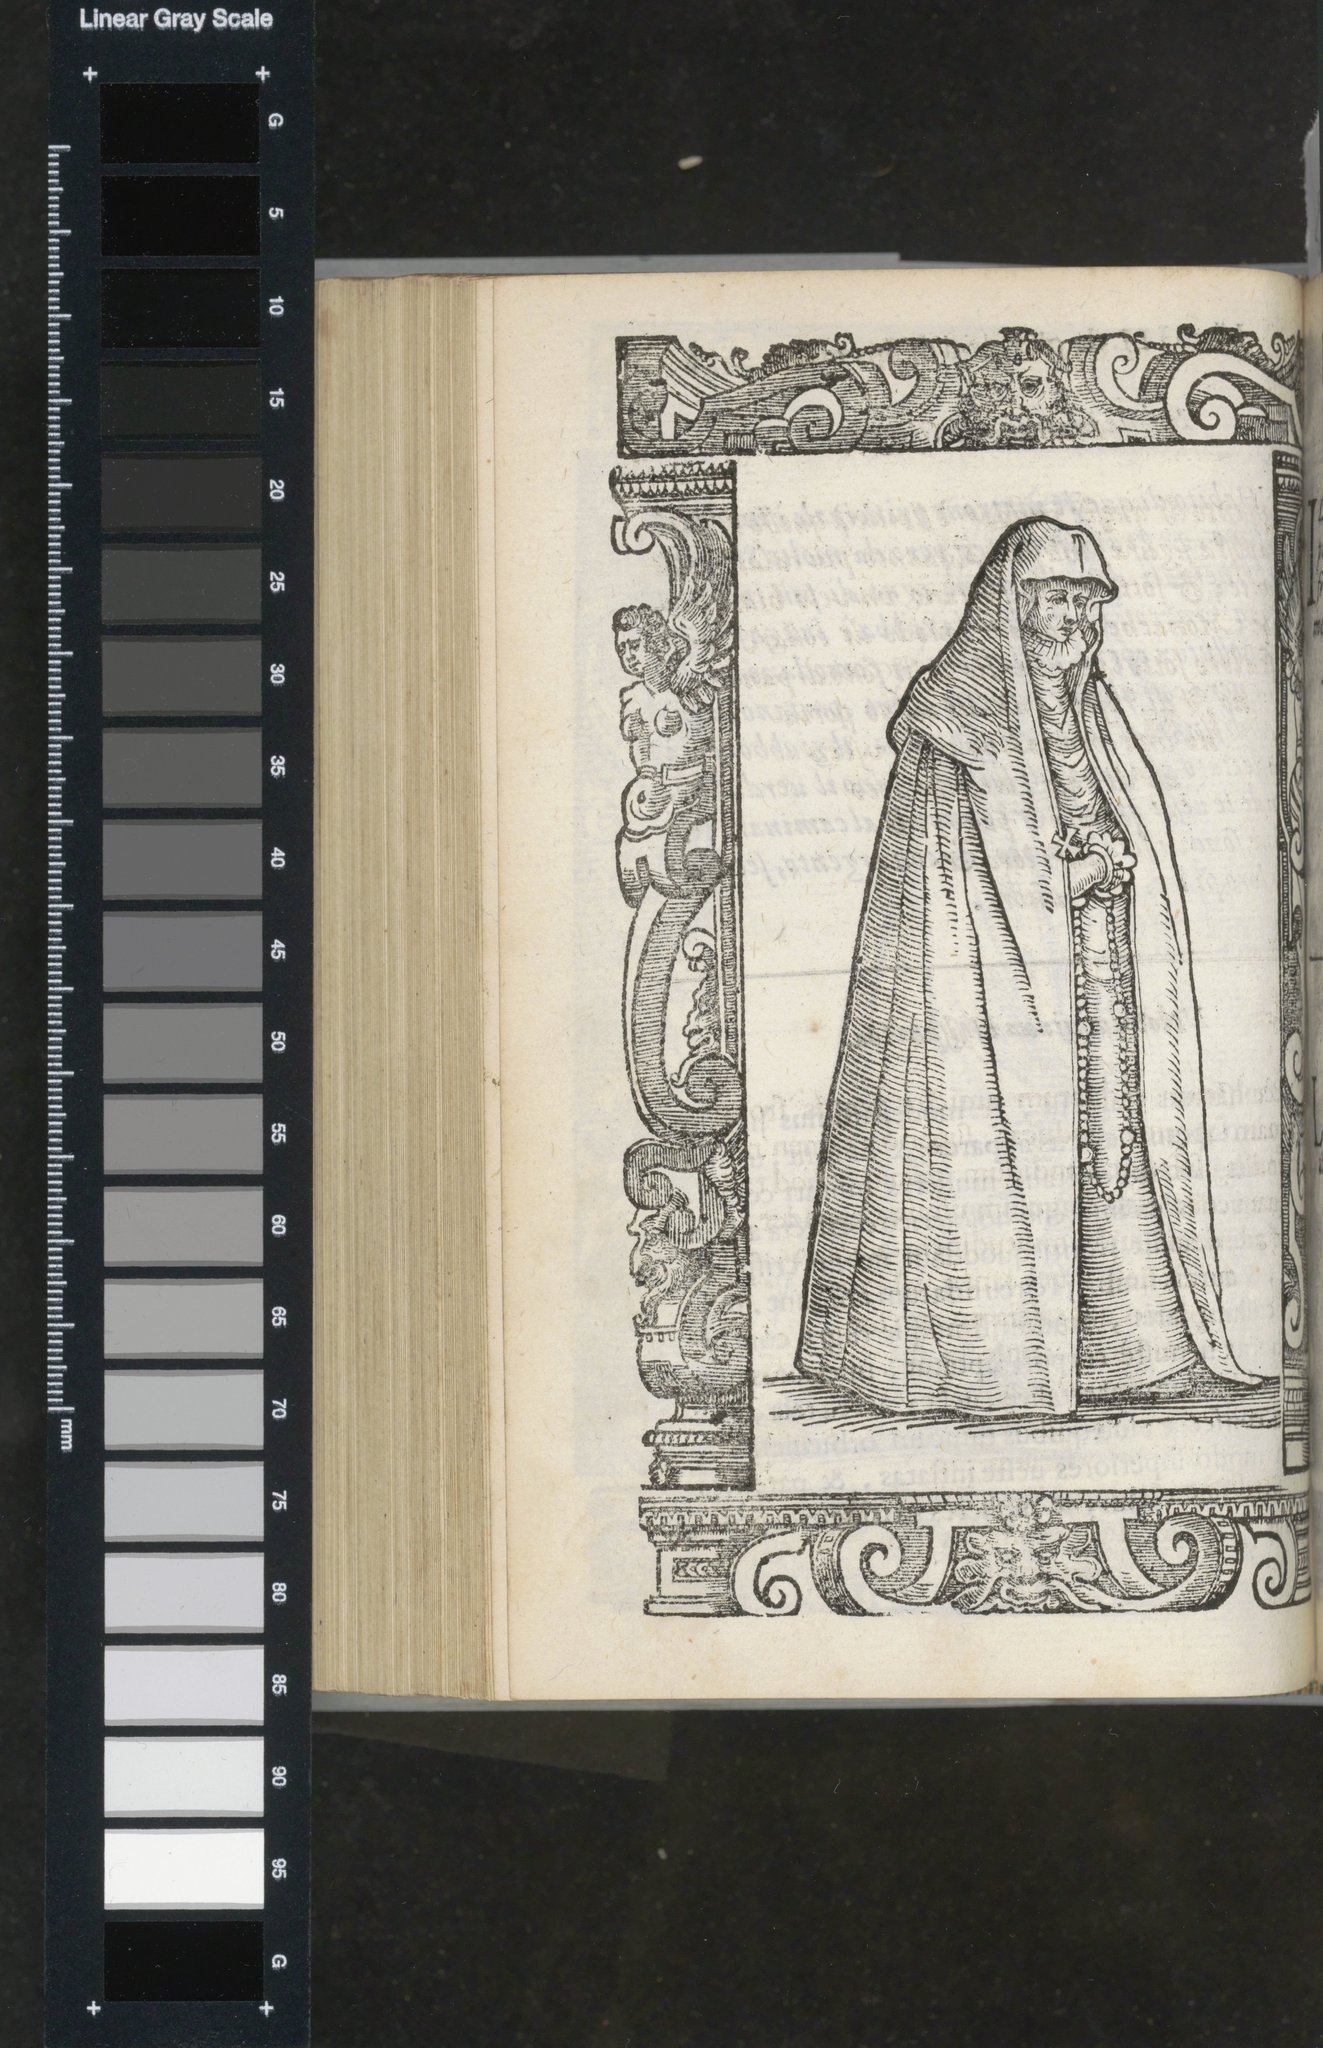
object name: costume print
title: Vedova nobile di Spagna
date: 1598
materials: paper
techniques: woodcut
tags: fashion plates